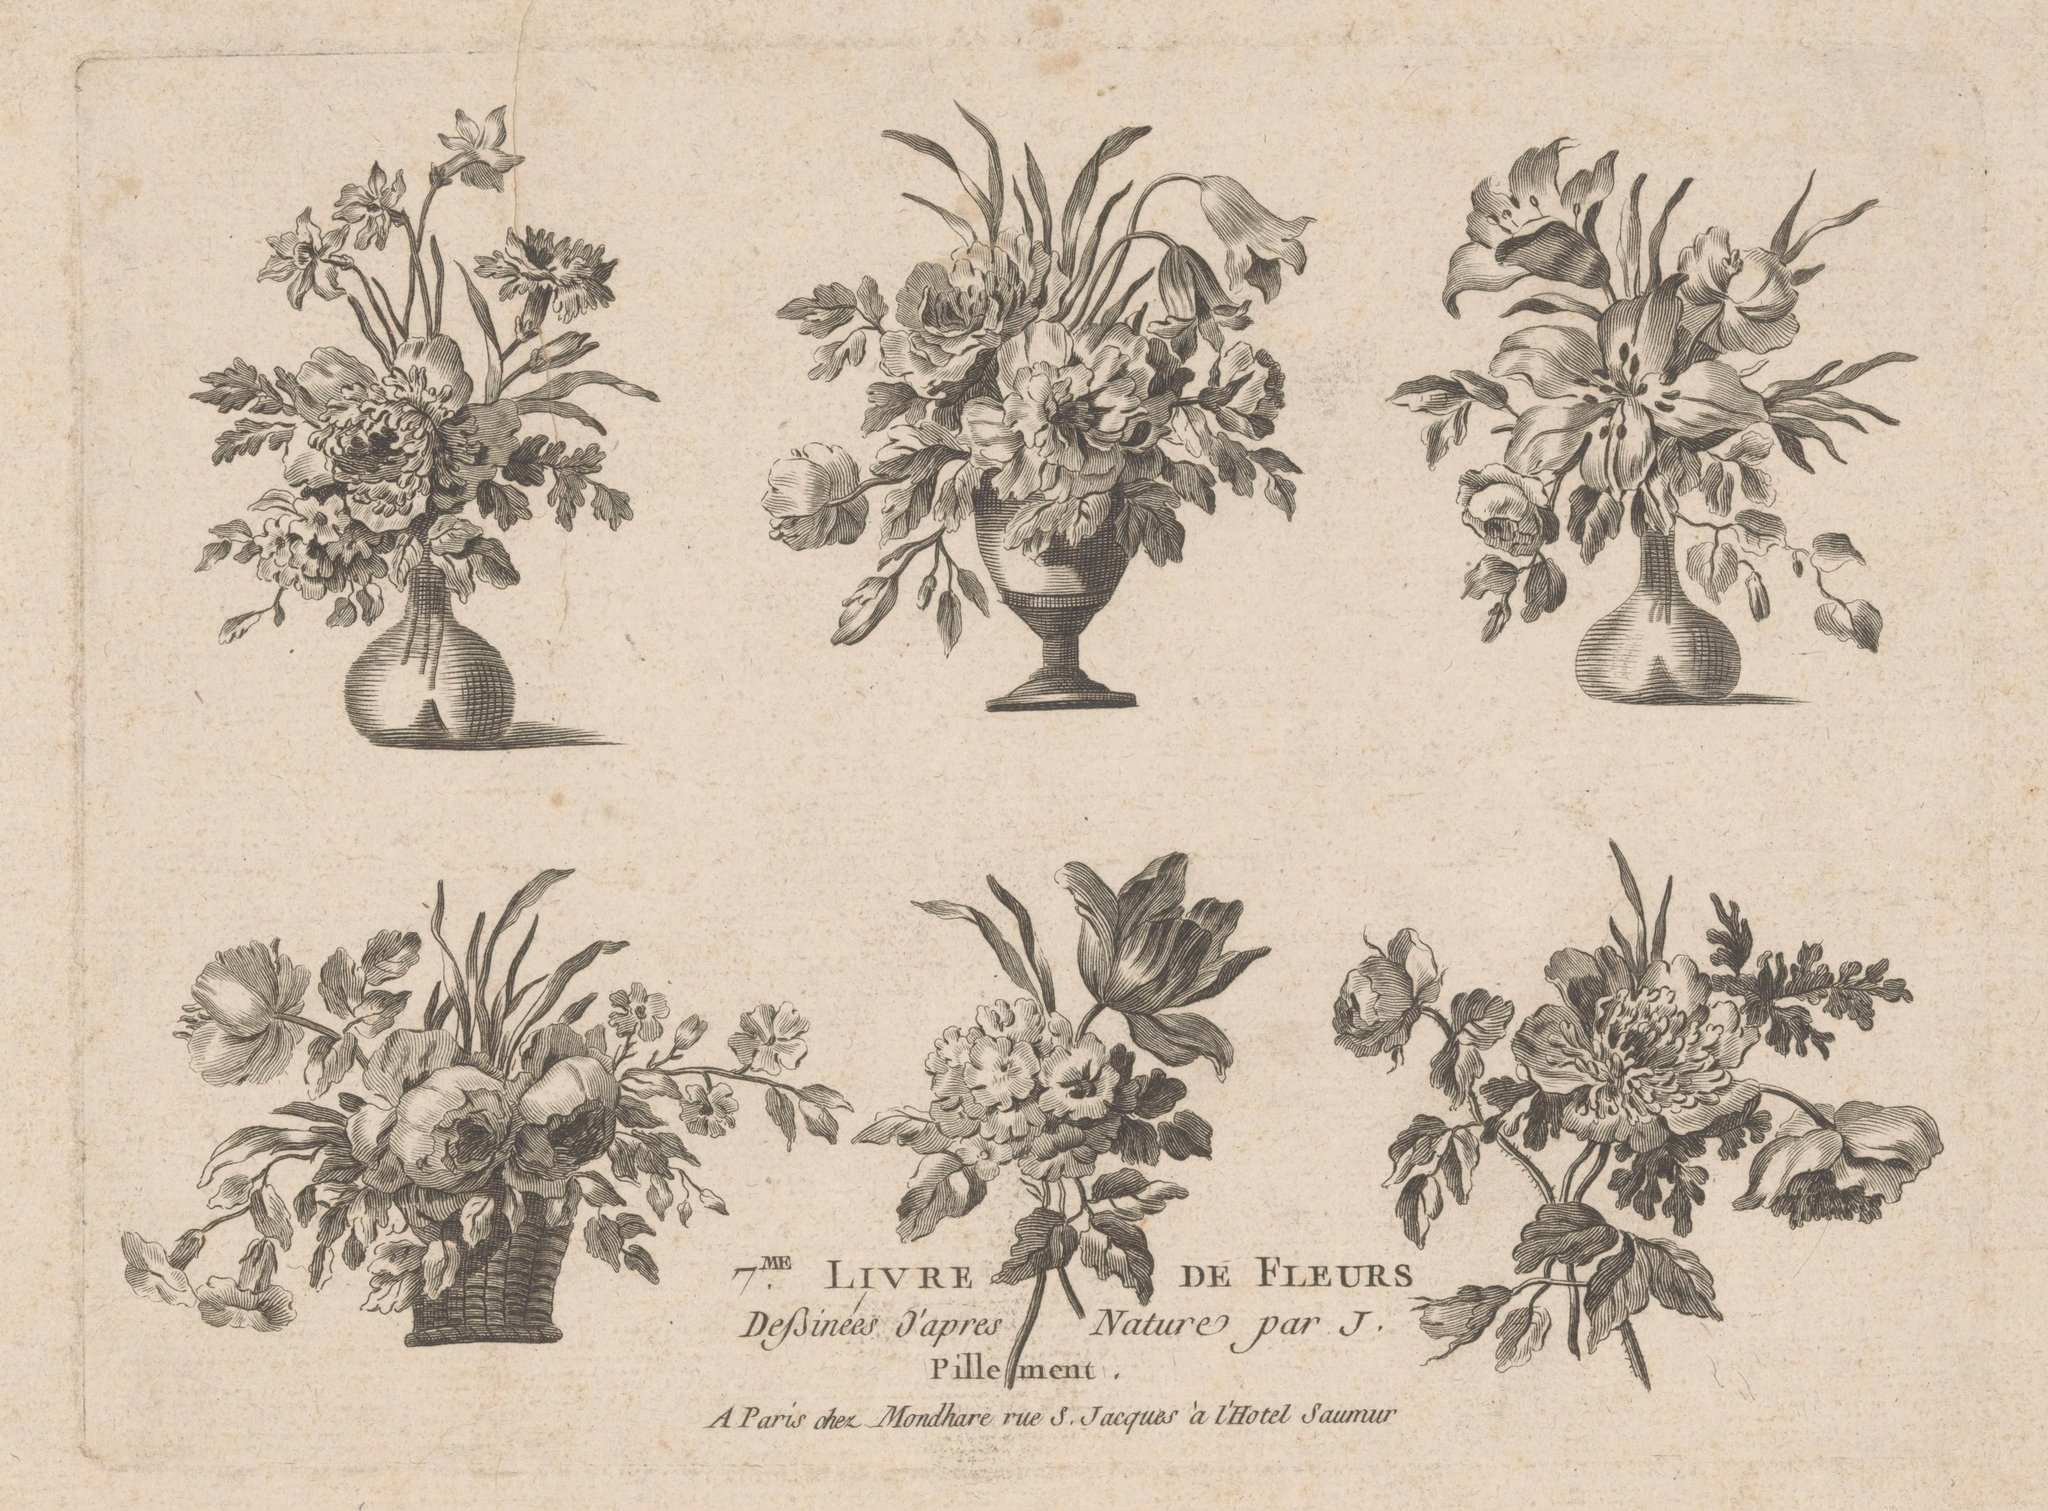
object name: titelprent, frontispice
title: 7me Livre de Fleurs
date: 1760-1784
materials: paper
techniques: etching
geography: paris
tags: flowers in a vase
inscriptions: collector's mark: Lugt 2760, collector's mark: Lugt 2228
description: Links boven een vaas met rozen en narcissen. Midden boven een vaas met rozen en tulpen. Rechts boven een vaas met lelies. Links onder een mand met rozen. Midden onder een hortensia. Rechts onder rozen.